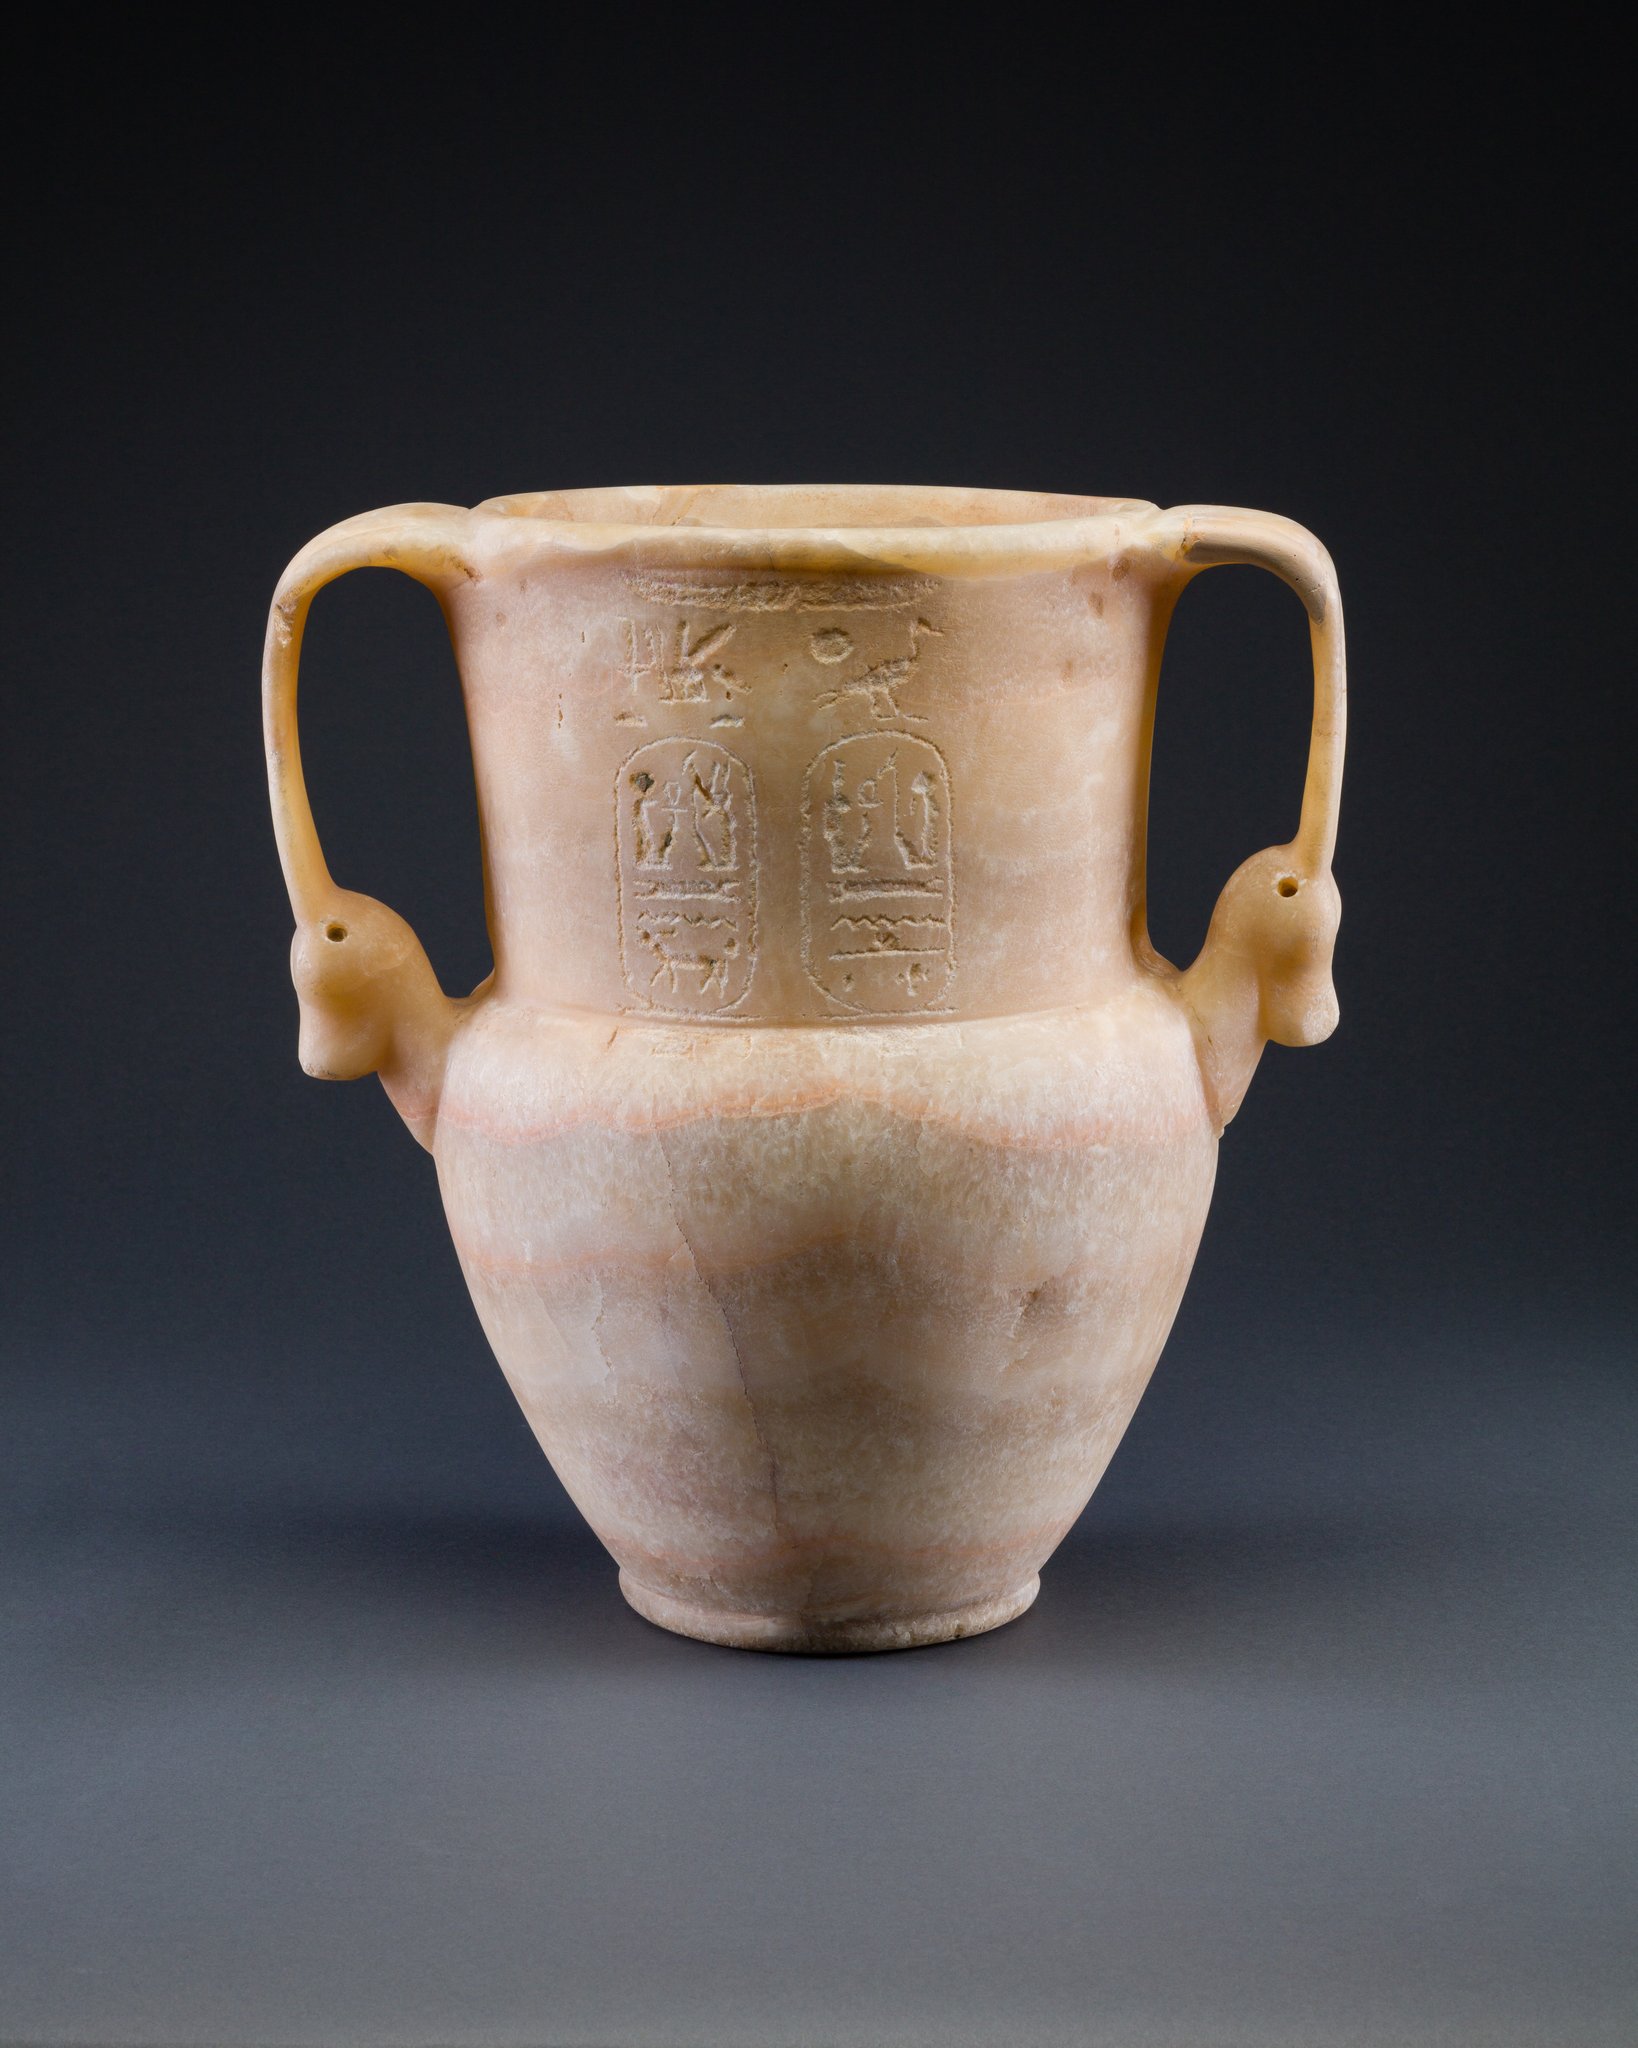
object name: jar, merneptah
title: Jar with Cartouches of Merneptah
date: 1213-1203 BCE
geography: egypt